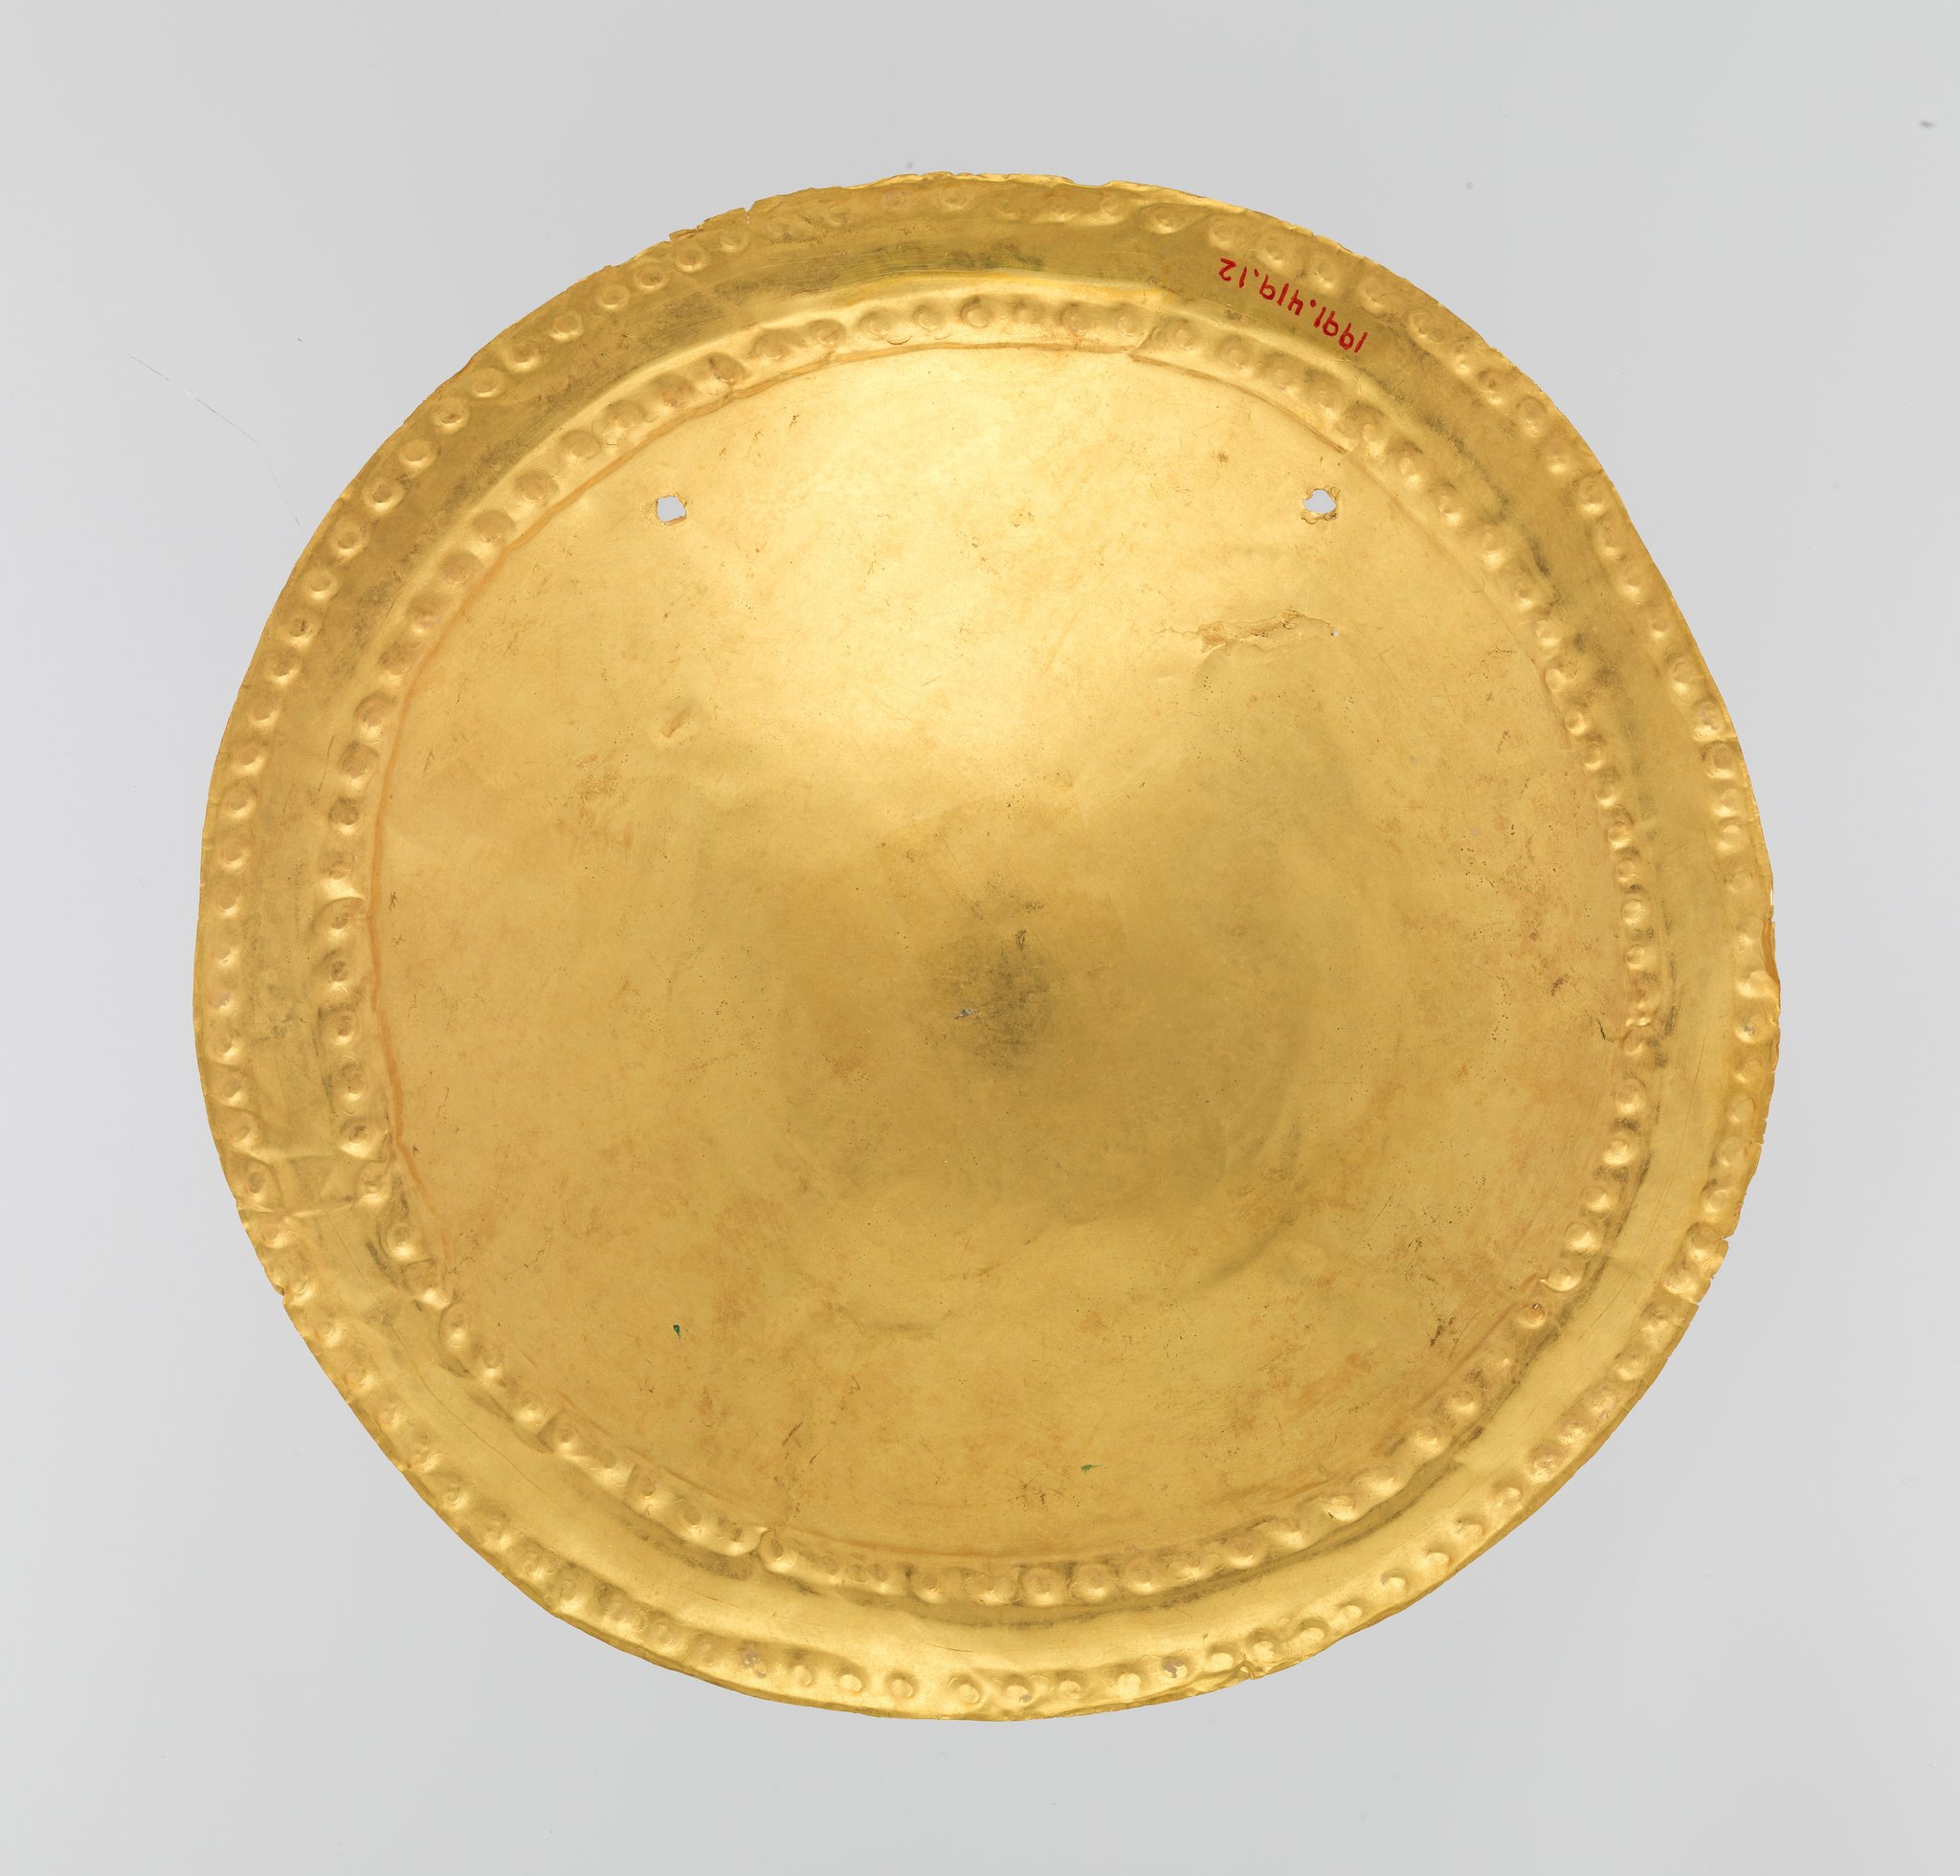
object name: pectoral disk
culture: coclé, macaracas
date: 701-1200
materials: gold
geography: panama